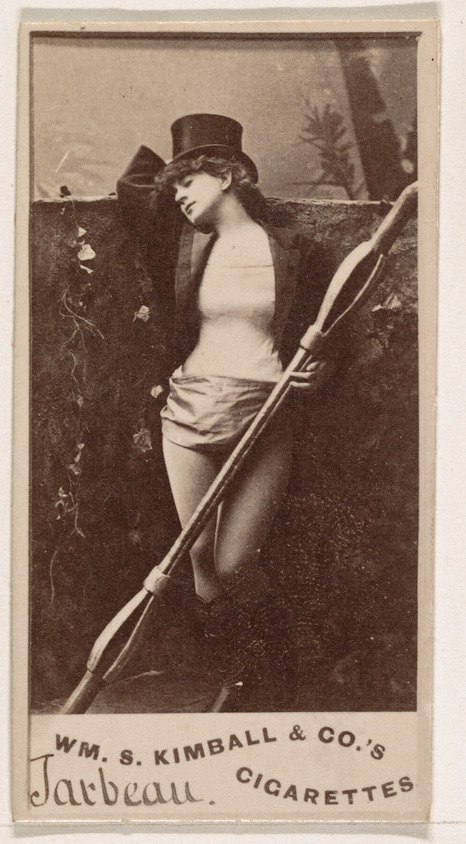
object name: photograph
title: Miss Jarbeau, from the Actresses series (N203) issued by Wm. S. Kimball & Co.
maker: william s. kimball & company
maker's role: publisher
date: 1889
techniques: color lithograph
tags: profiles,women,actresses